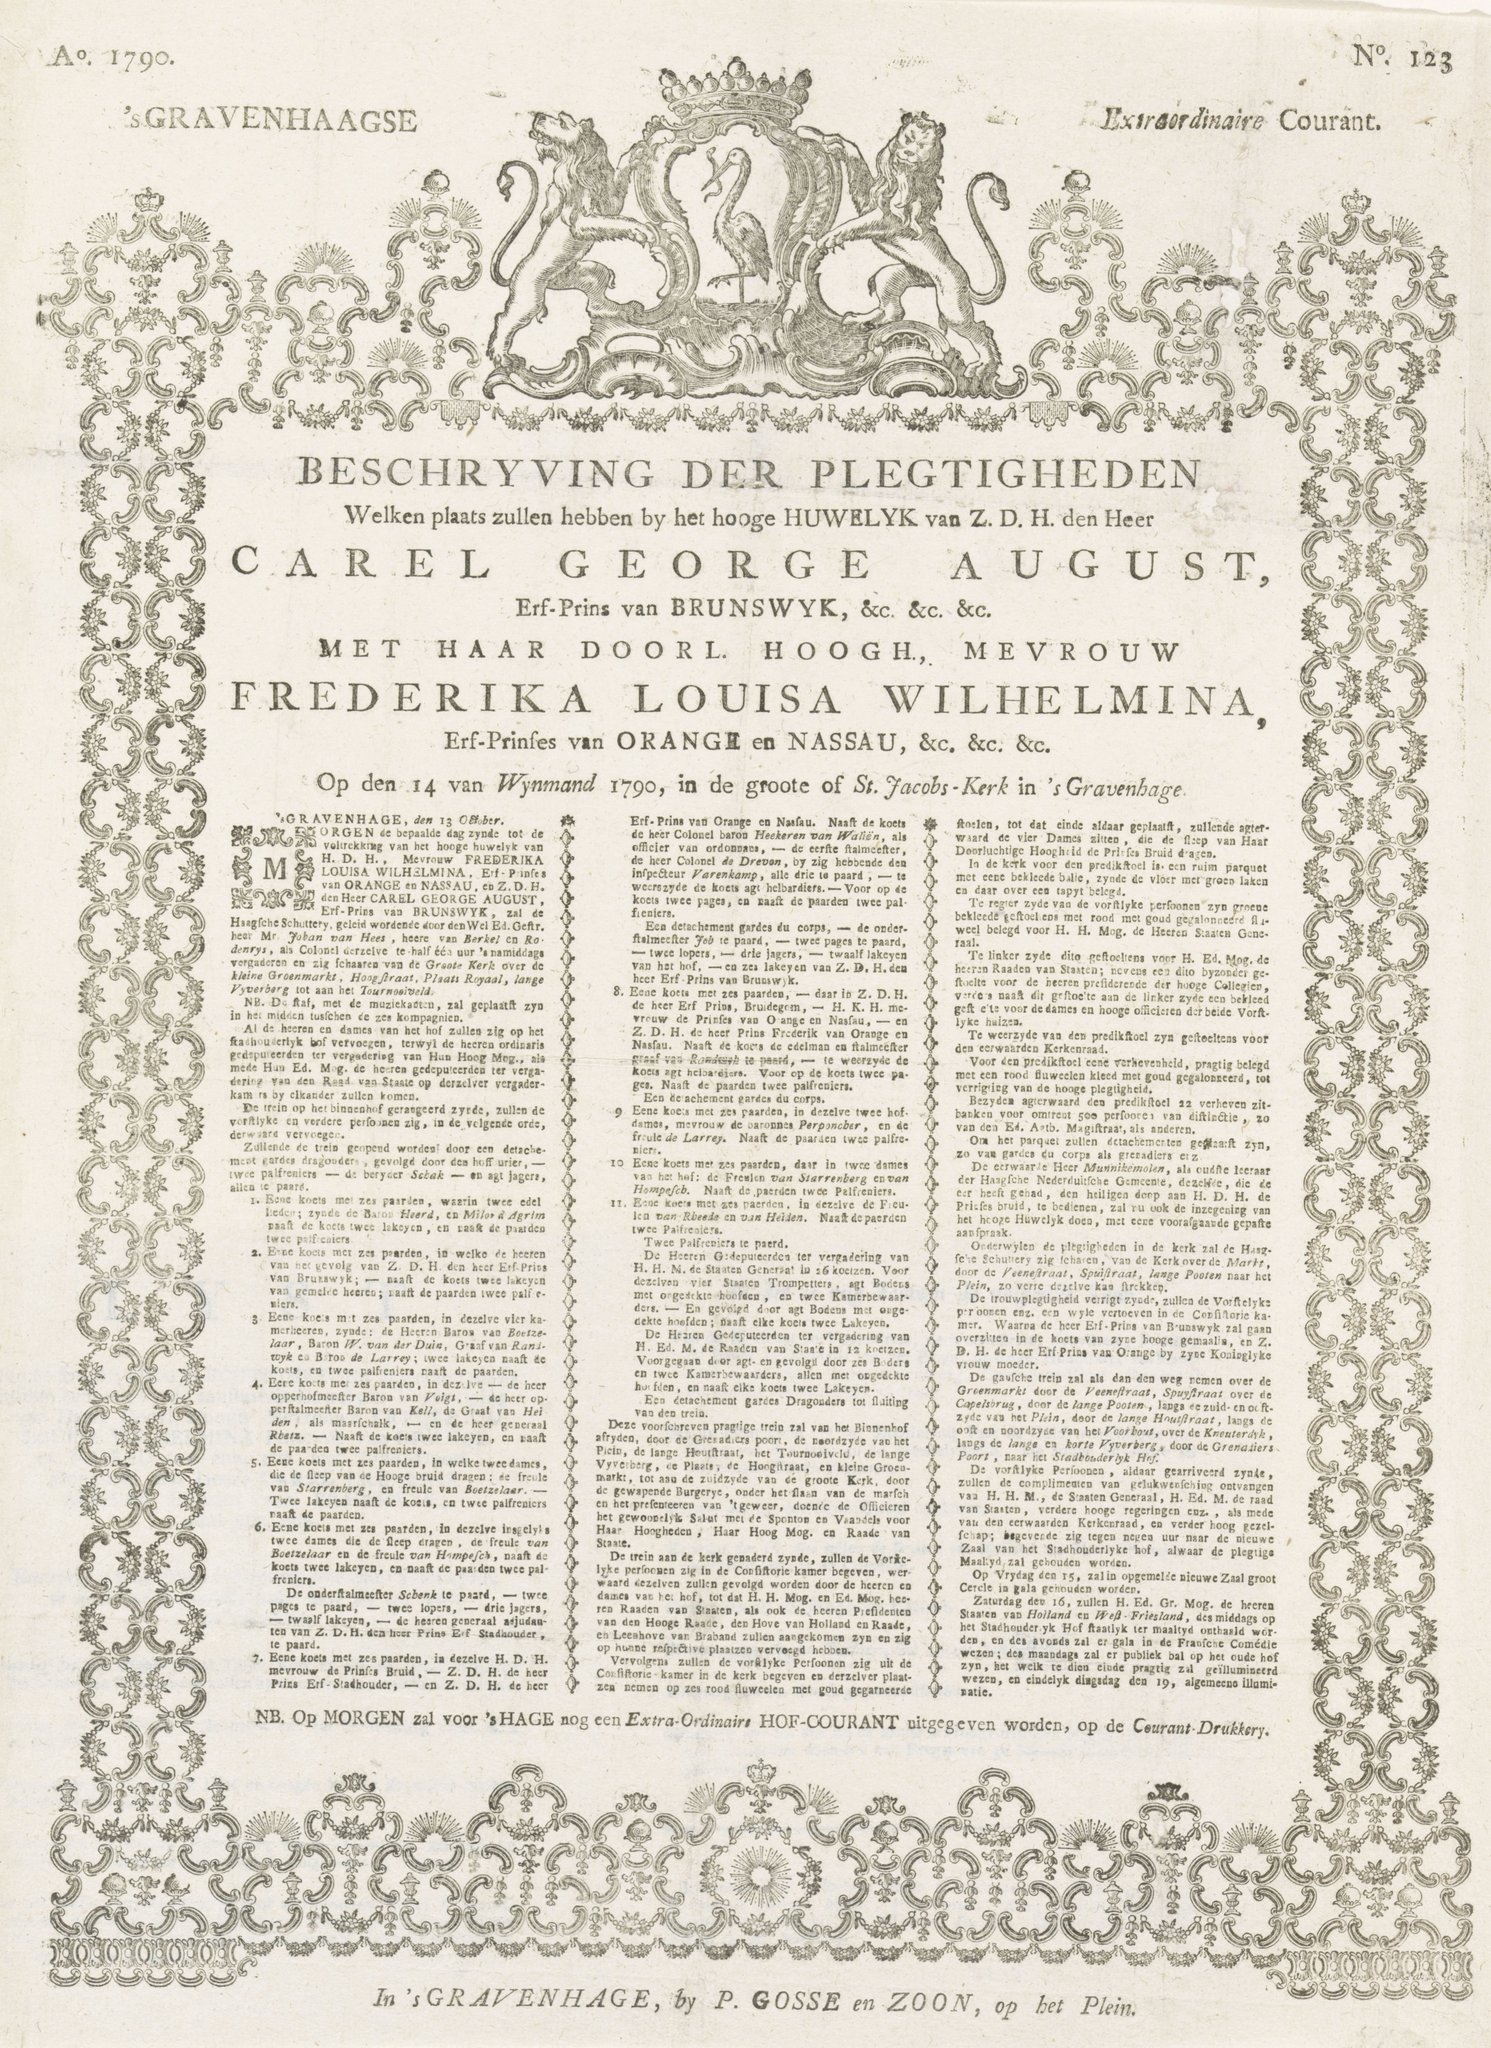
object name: newspaper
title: Krant met het nieuws over het huwelijk van prinses Louise van Oranje-Nassau met Karel van Brunswijk-Wolfenbüttel, 1790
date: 1790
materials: paper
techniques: letterpress printing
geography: the hague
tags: karel van brunswijk-wolfenbüttel, louise (prinses van oranje-nassau), the hague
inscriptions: collector's mark: Lugt 2166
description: Aflevering nr. 123 van de 's Gravenhaagse Extraordinaire Courant van 13 oktober 1790. Beschrijving van de plechtigheden die zullen plaatsvinden tijdens het huwelijk van prinses Louise van Oranje-Nassau en Karel van Brunswijk-Wolfenbüttel op 14 oktober 1790 te Den Haag. Tekst binnen een decoratieve kader van fileten, bovenaan een vignet met het stadswapen van Den Haag.